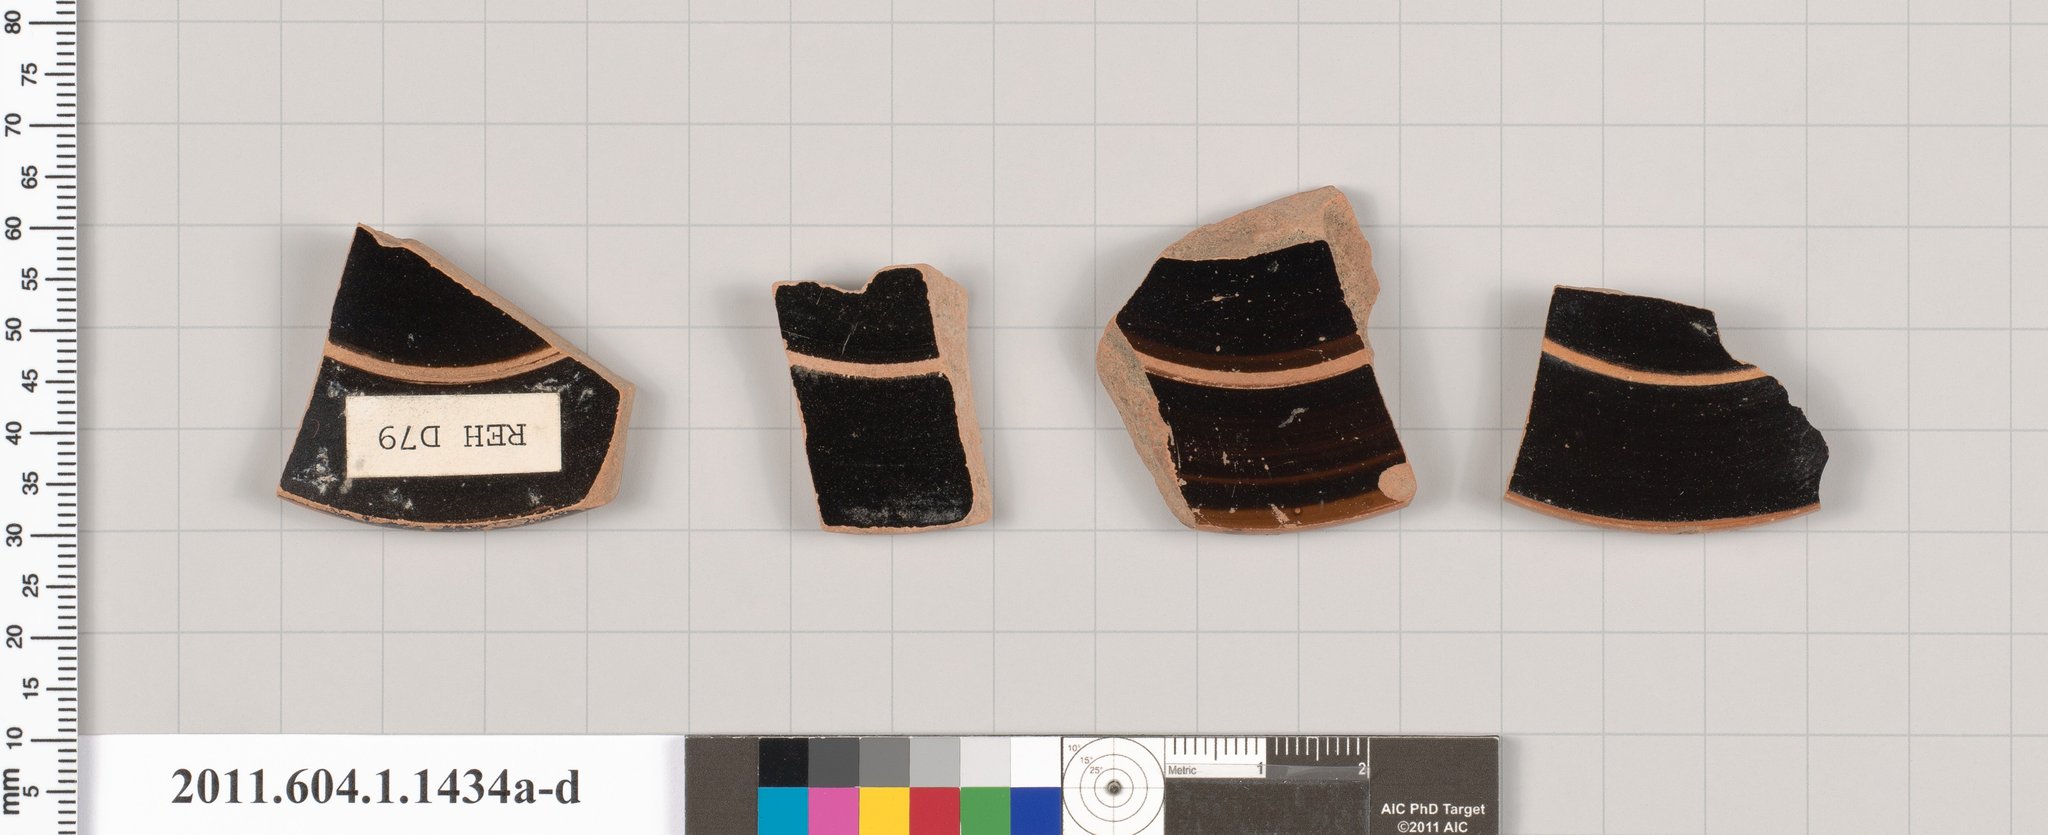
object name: kylix fragment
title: Terracotta fragments of kylikes (drinking cups)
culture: greek, attic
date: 500-401 BCE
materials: terracotta